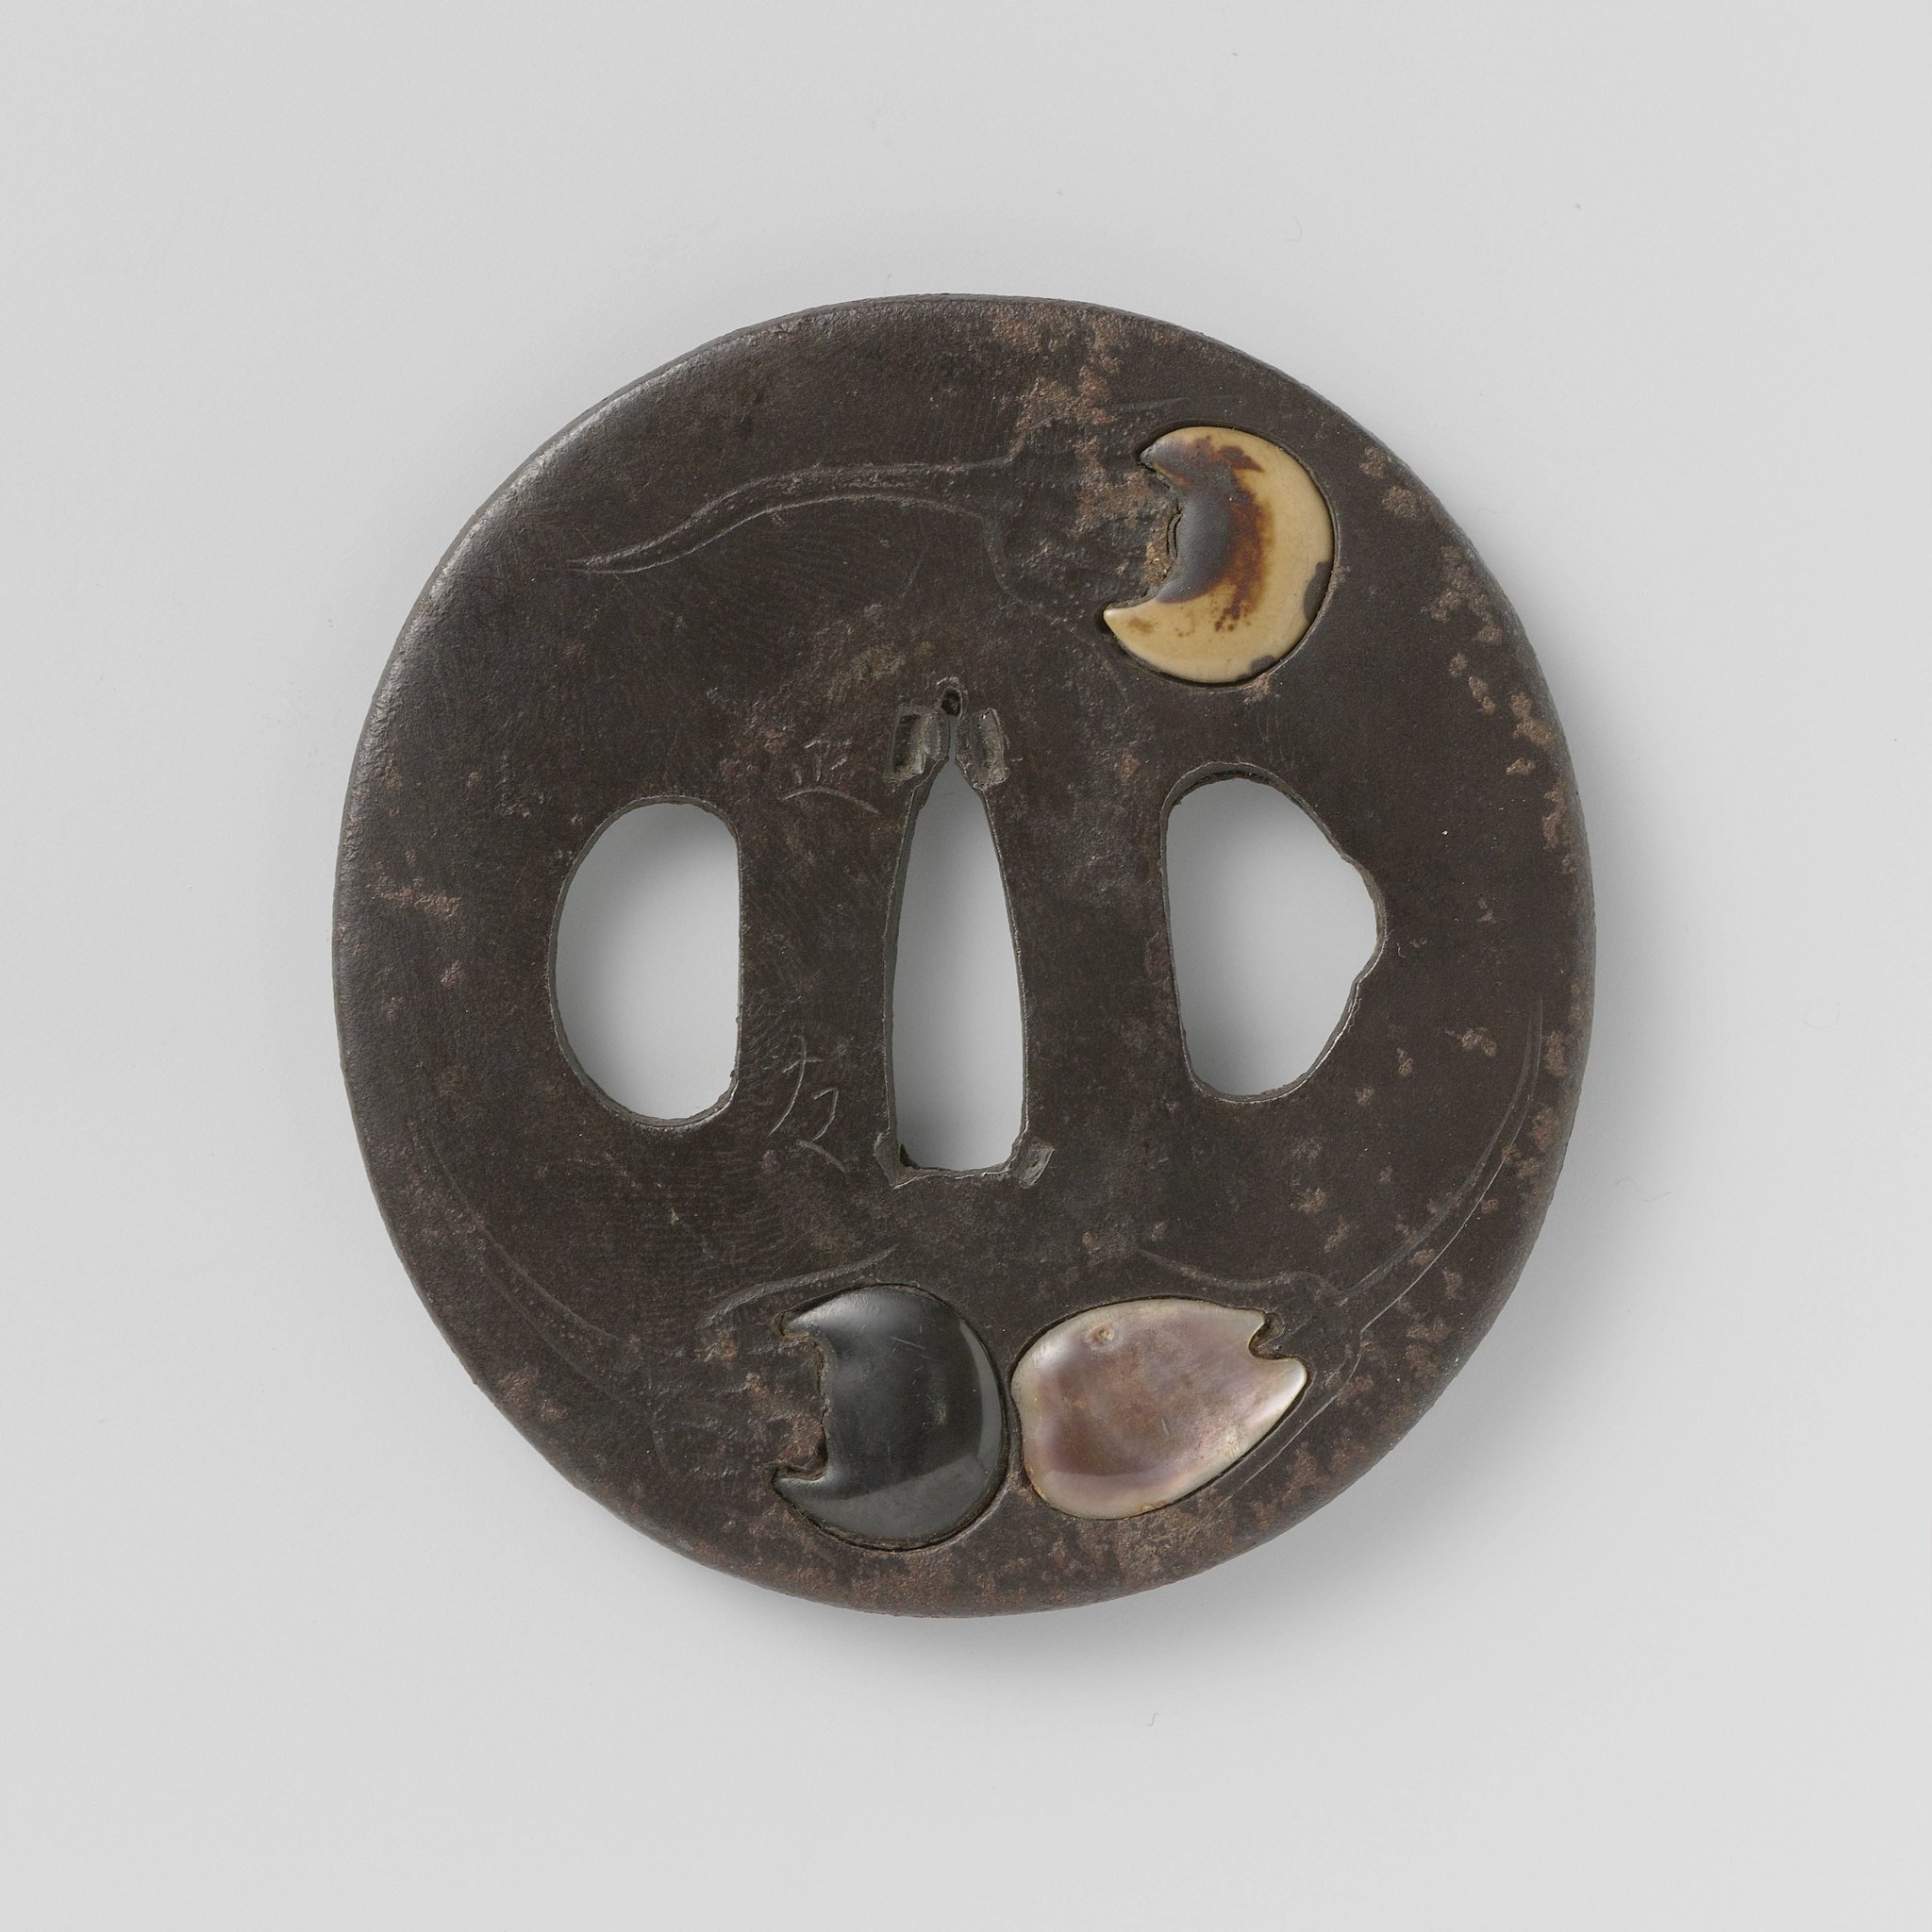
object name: tsuba, zwaardstootplaat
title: Hand guard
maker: masatomo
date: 1600-1900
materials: iron, mother of pearl, gemstone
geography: japan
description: Ovale tsuba aan beide zijden ingelegd met verschillende steensoorten die drie aubergines voorstellen; gesigneerd "masatomo".